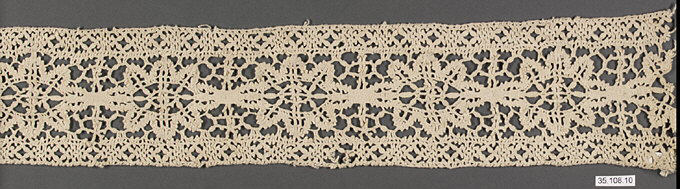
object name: border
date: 1567-1600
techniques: lace